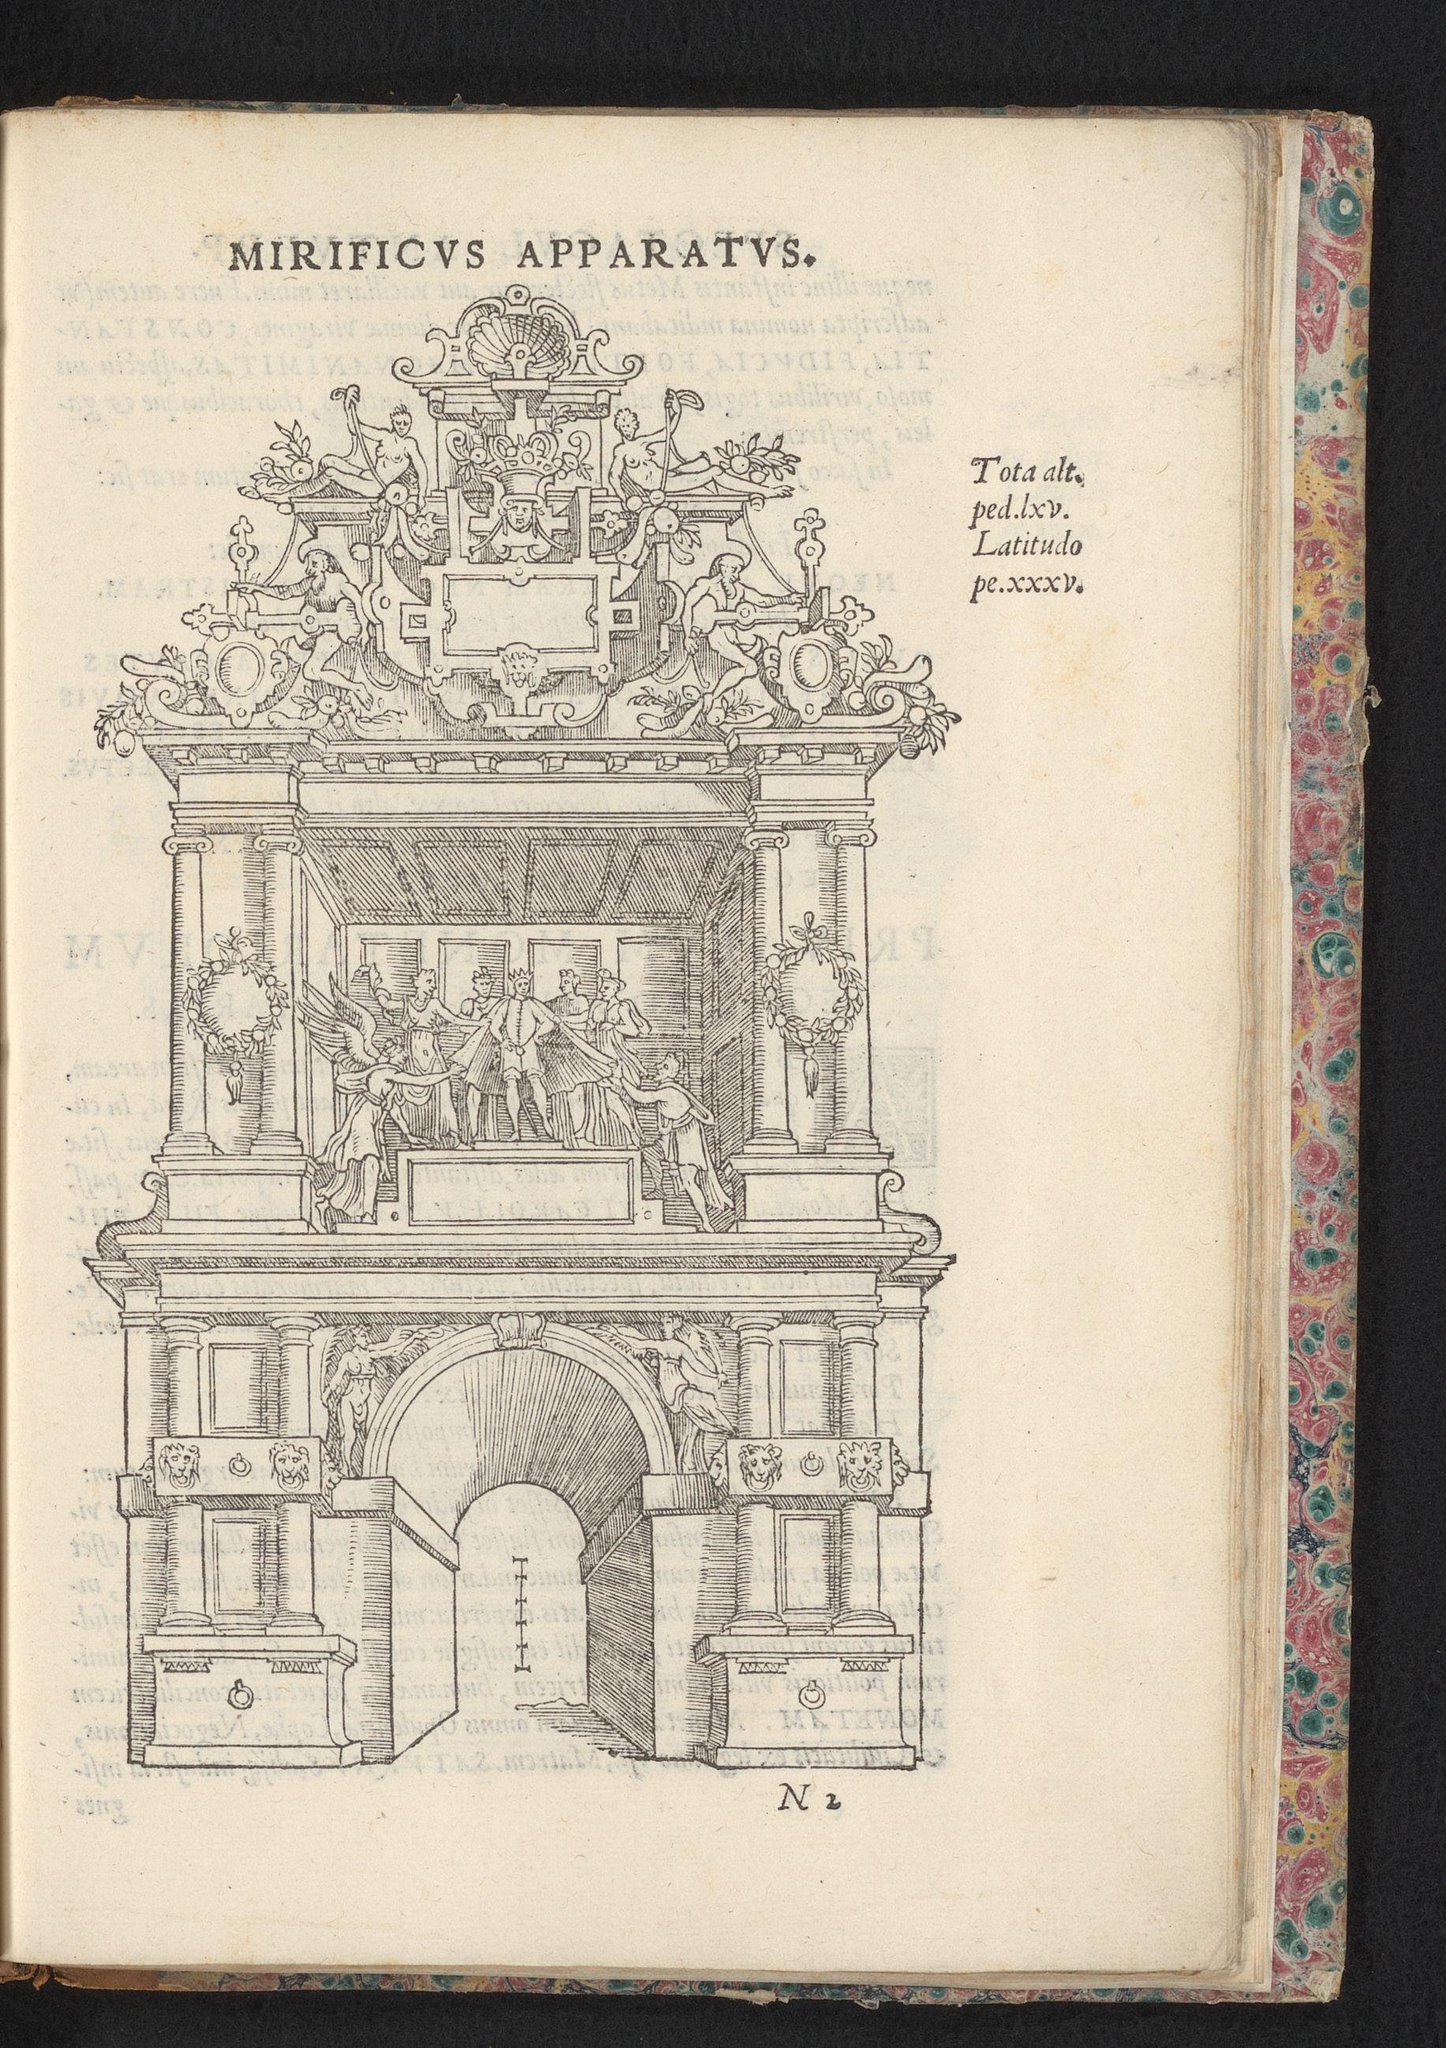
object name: print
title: Arcus publicus ad portam divi Ioannis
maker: pieter coecke van aelst (i)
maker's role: draughtsman, print maker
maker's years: 1502-1550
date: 1549-1550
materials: paper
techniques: woodcut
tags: philip ii of spain, 'tableau vivant', triumphal arch, antwerp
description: Illustratie in: Spectaculorum in susceptione Philippi Hisp. Prin. Divi Caroli. V. Caes. F. ann 1549 Antverpiae aeditorum, mirificus apparatus. Tekst van Cornelius Grapheus, opgedragen aan Filips II, uitgegeven met keizerlijke privilege door Pieter Coecke van Aelst, gedrukt door Gillis van Diest. Boek in de bibliotheek met signatuur: 325 B 13.